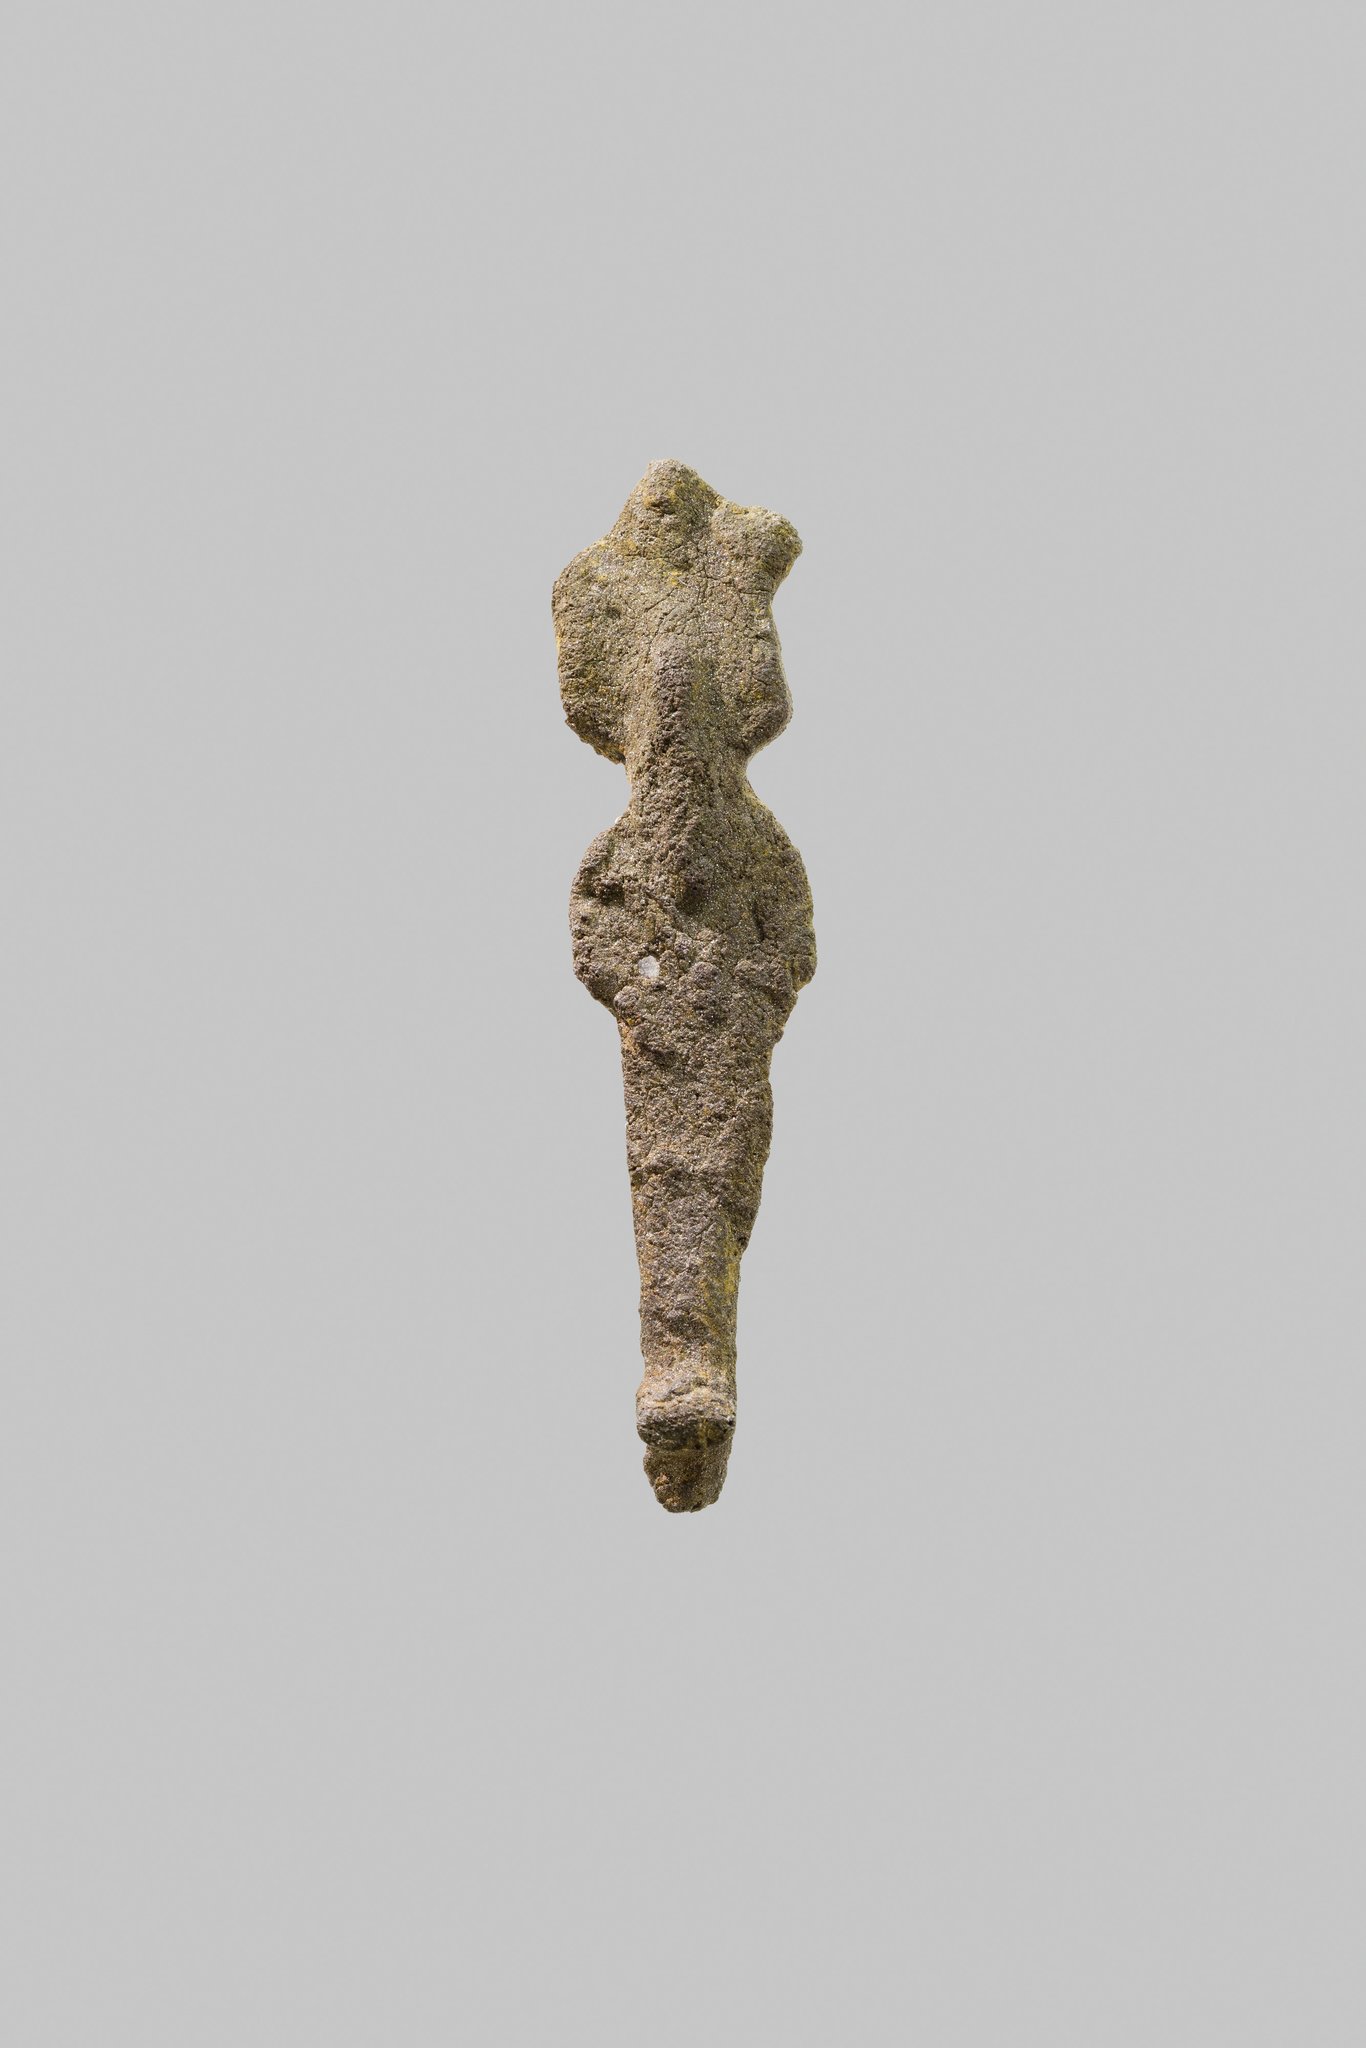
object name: statuette, osiris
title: Osiris Figure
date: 712-30 BCE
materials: bronze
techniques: inlay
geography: egypt